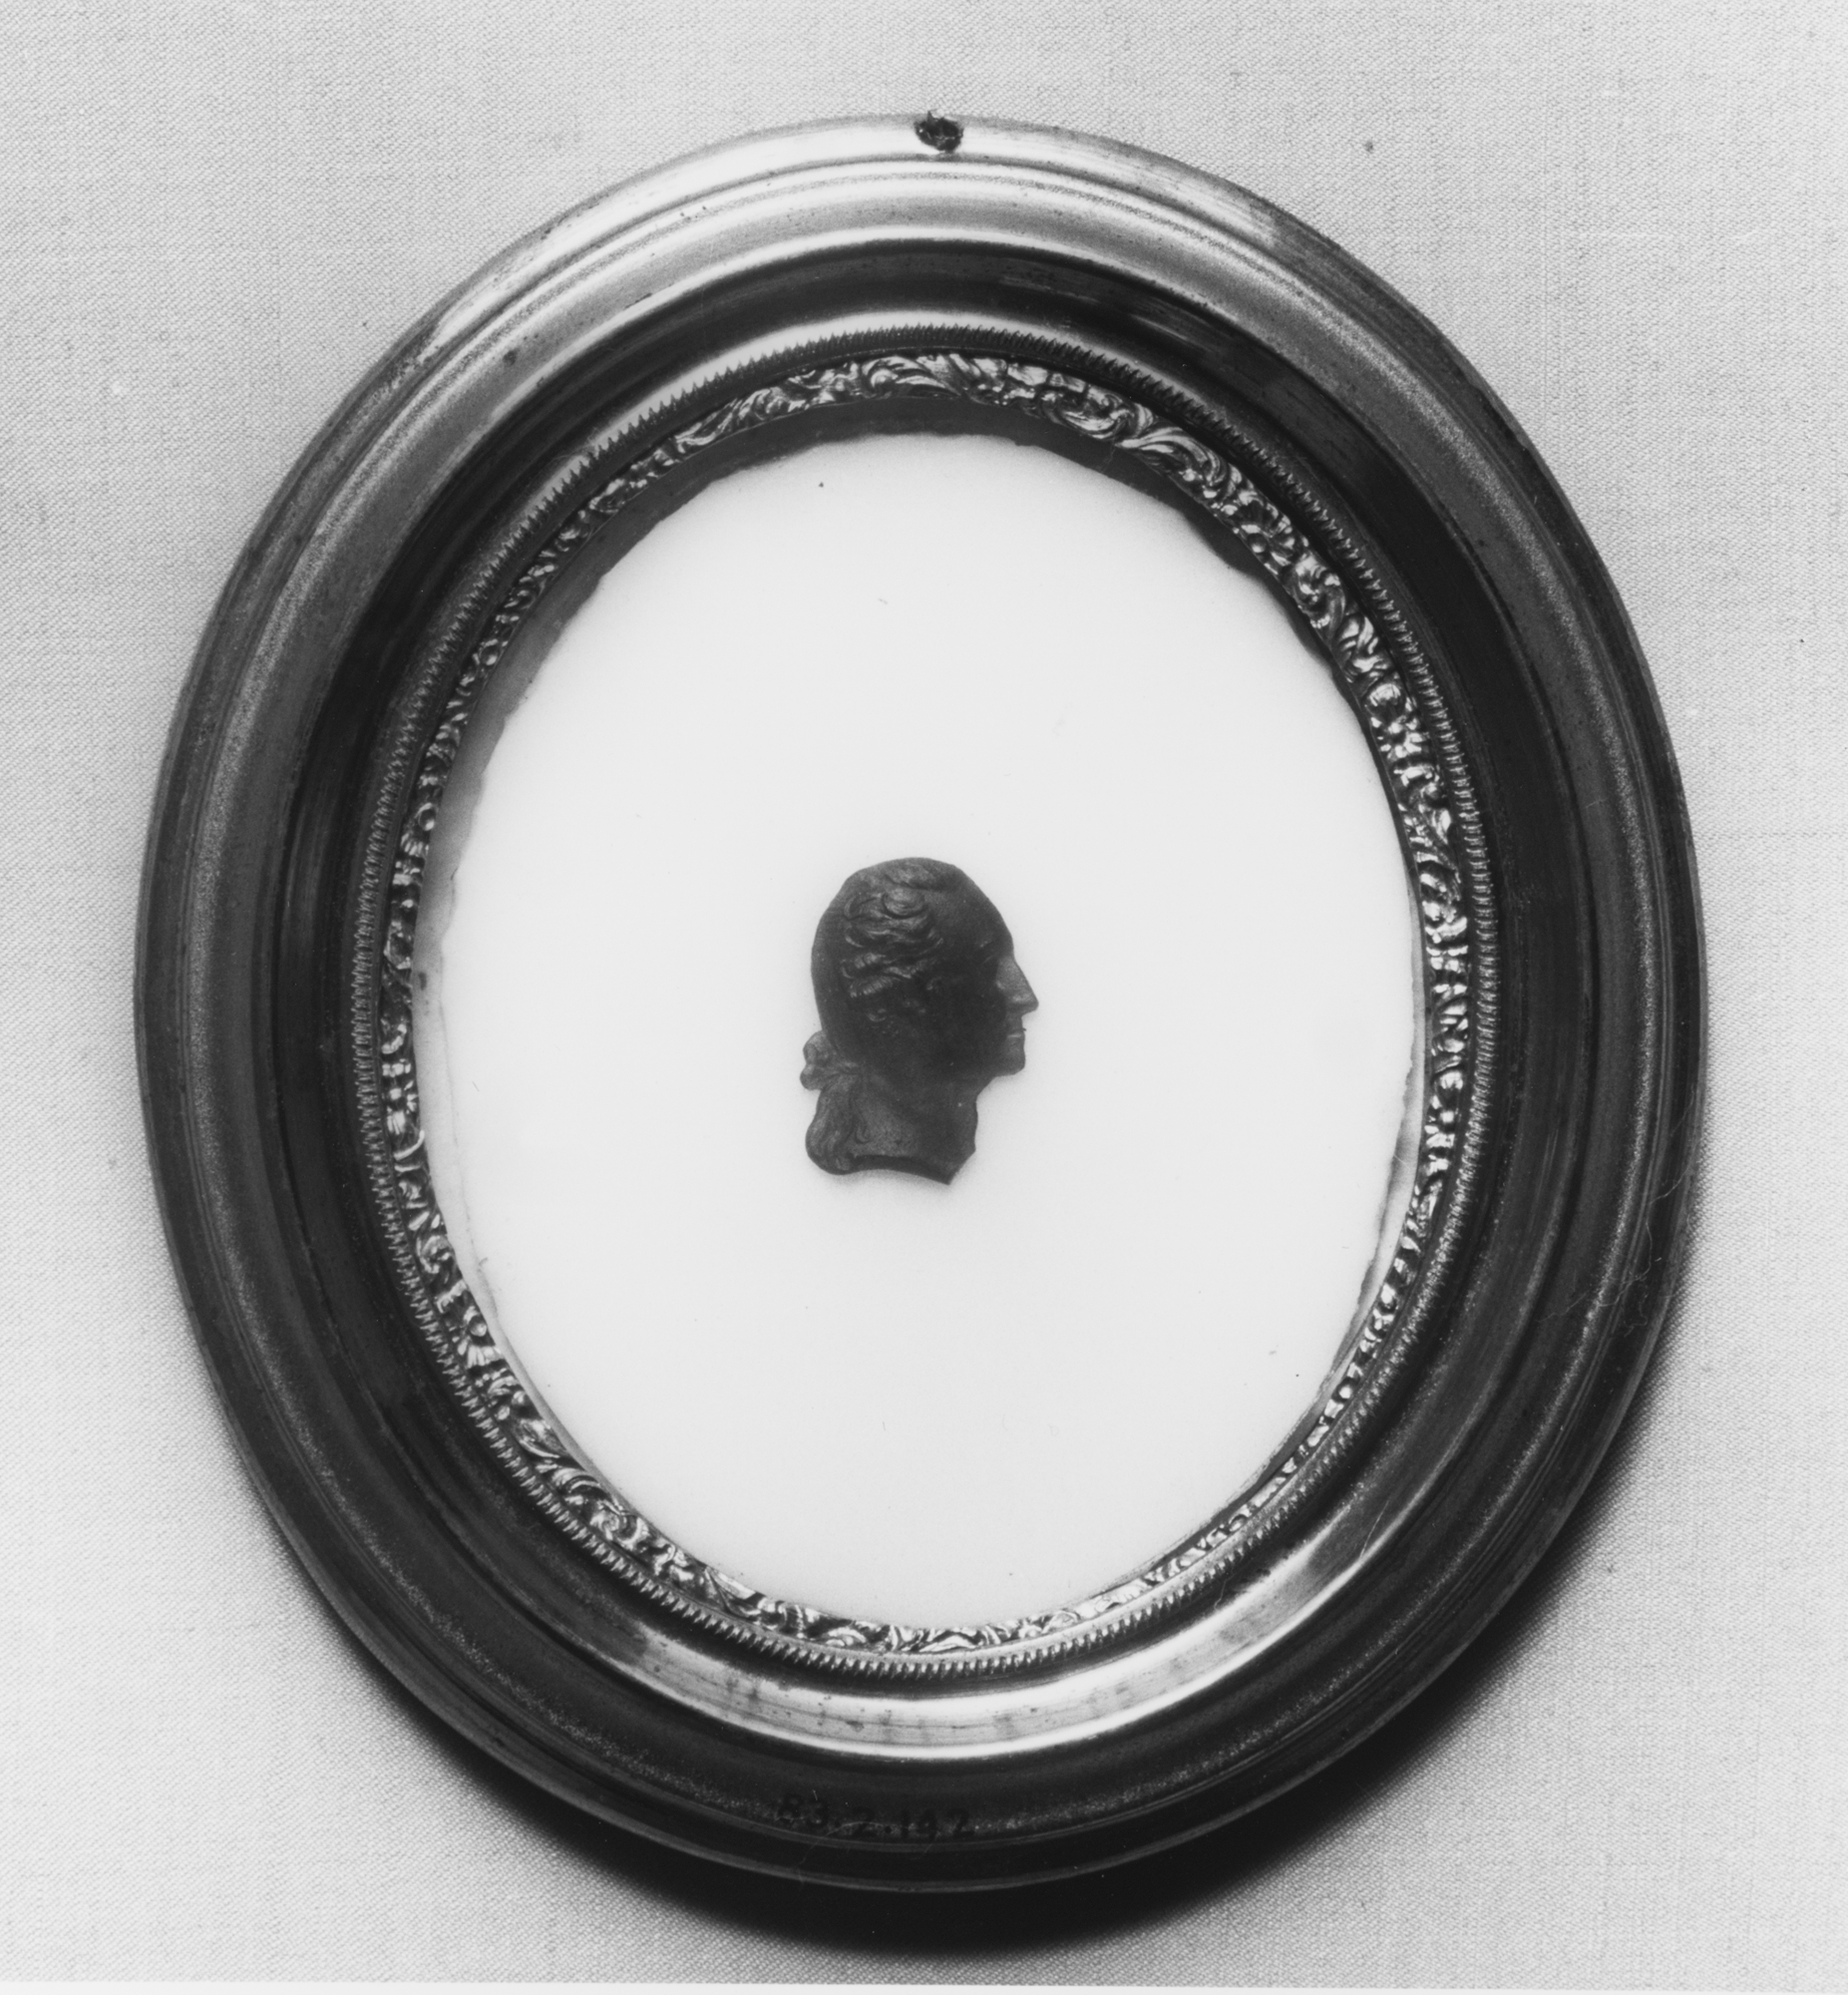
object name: plaque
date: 1776-1830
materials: glass, paste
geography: england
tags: men,profiles